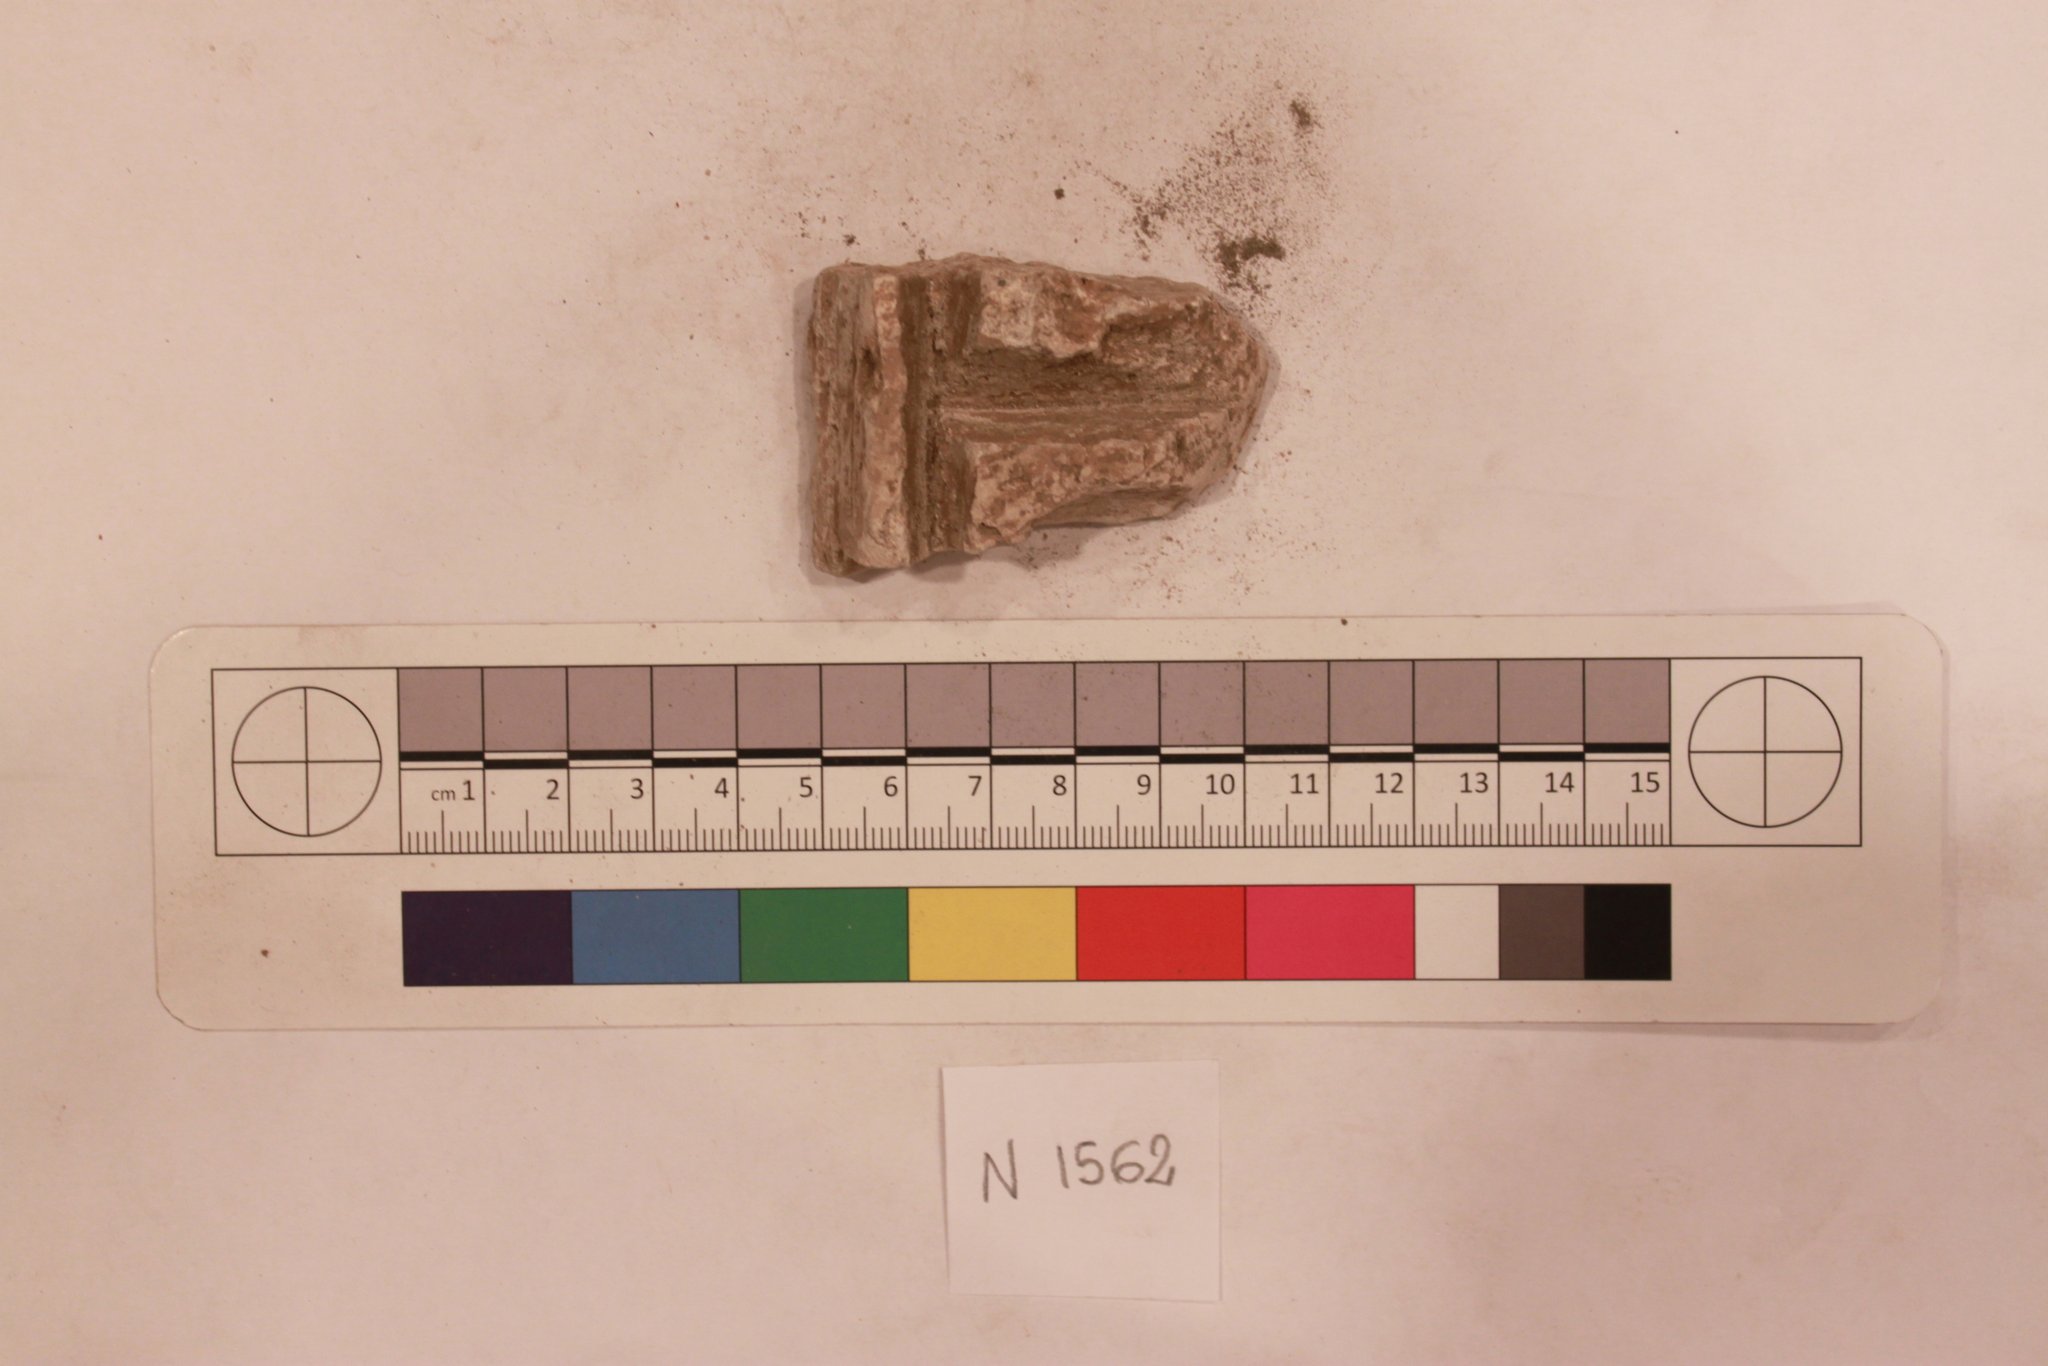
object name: fragment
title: Stucco Fragment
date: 701-1200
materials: plaster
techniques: carving, painting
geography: iran